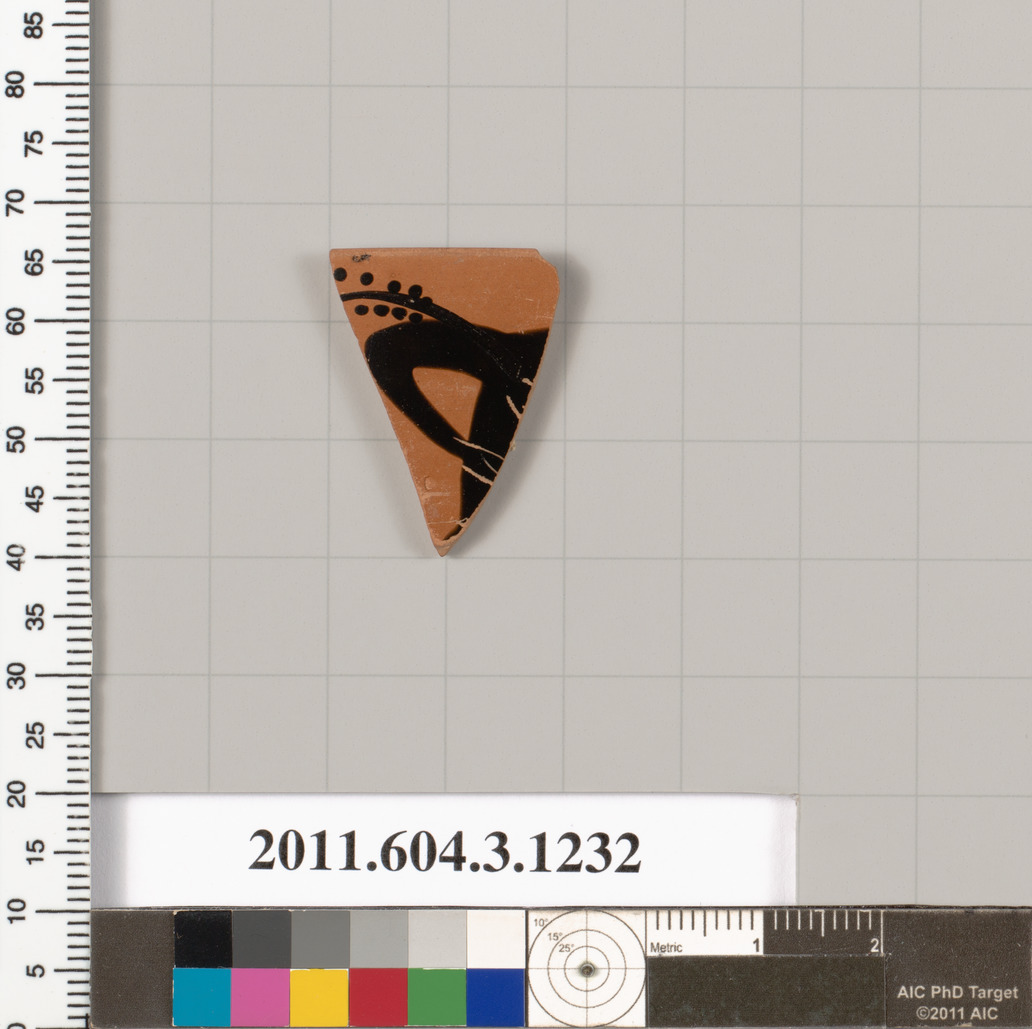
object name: kyathos fragment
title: Terracotta rim fragment of a kyathos (cup-shaped ladle)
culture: greek, attic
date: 534-468 BCE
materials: terracotta